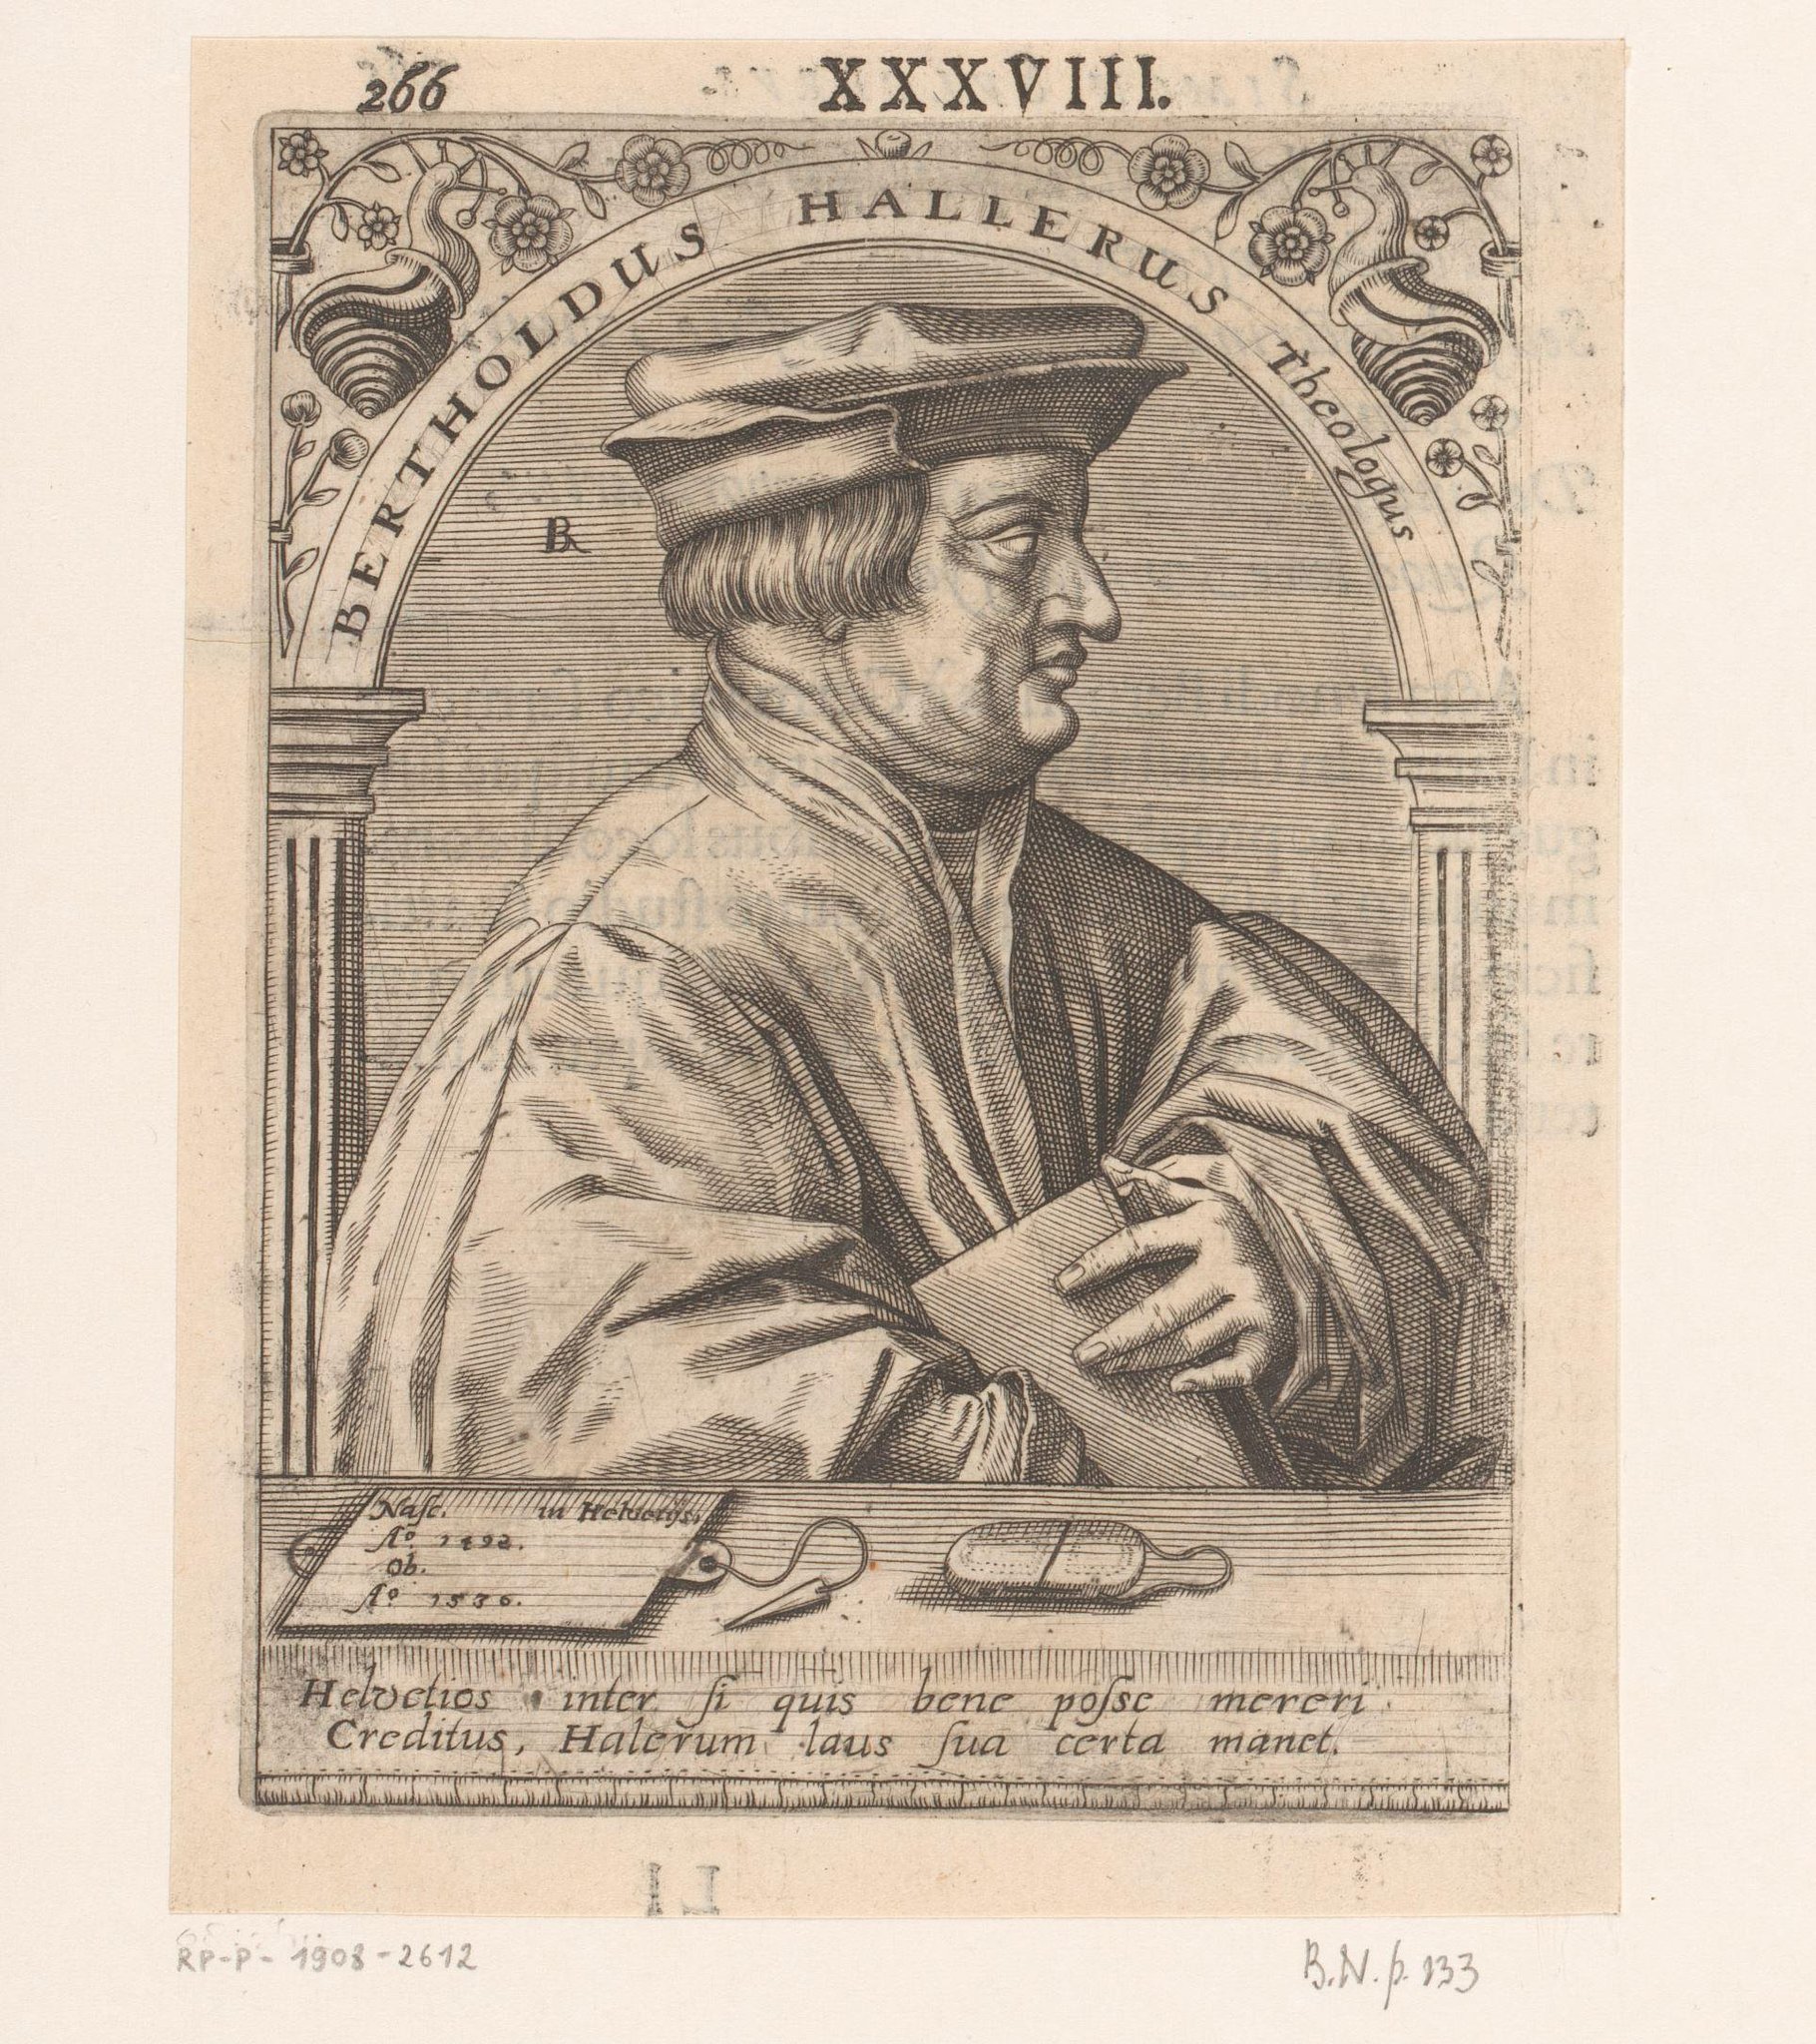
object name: book illustration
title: Bertholdus Hallerus Theologus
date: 1597-1599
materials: paper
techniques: engraving, letterpress printing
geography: france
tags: historical persons, book, molluscs: snail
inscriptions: collector's mark: Lugt 2228